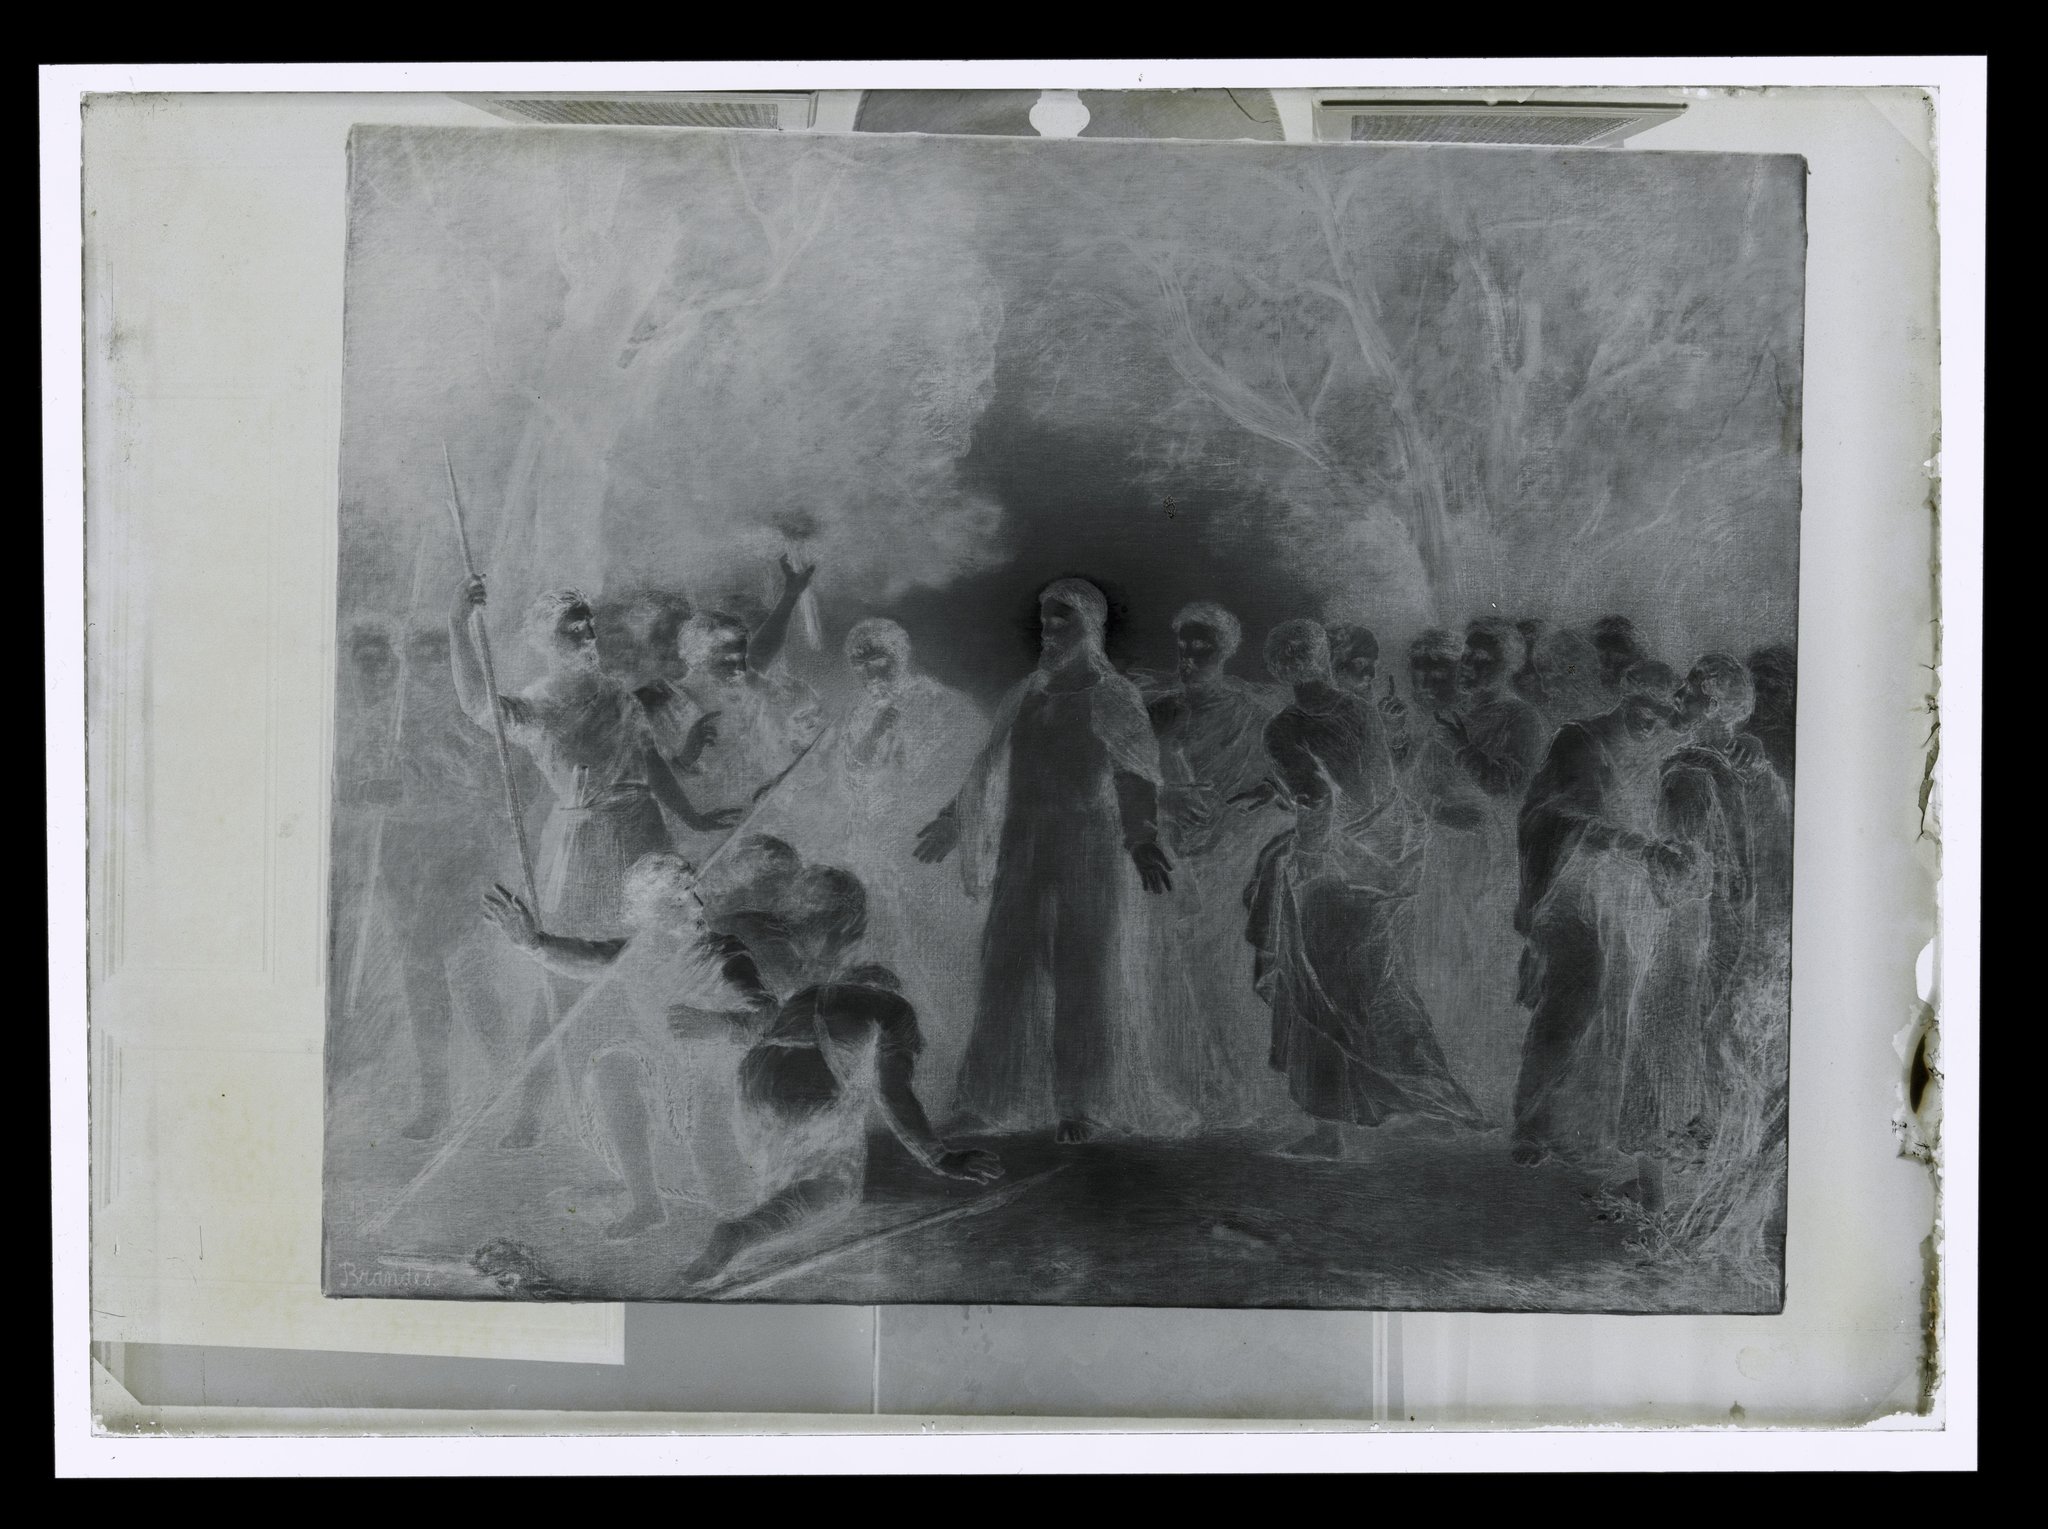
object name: reproduction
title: Fotoreproductie van een schilderij van Christus in een bos, door Laurens Lodewijk Kleijn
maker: laurens lodewijk kleijn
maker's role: draughtsman, painter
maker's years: 1826-1909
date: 1865-1900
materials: glass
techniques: collodion process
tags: christ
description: Onderdeel van een groep glasnegatieven uit de nalatenschap van de schilder Laurens Lodewijk Kleijn, met stillevens, portretten, zelfportretten en kunstreproducties.